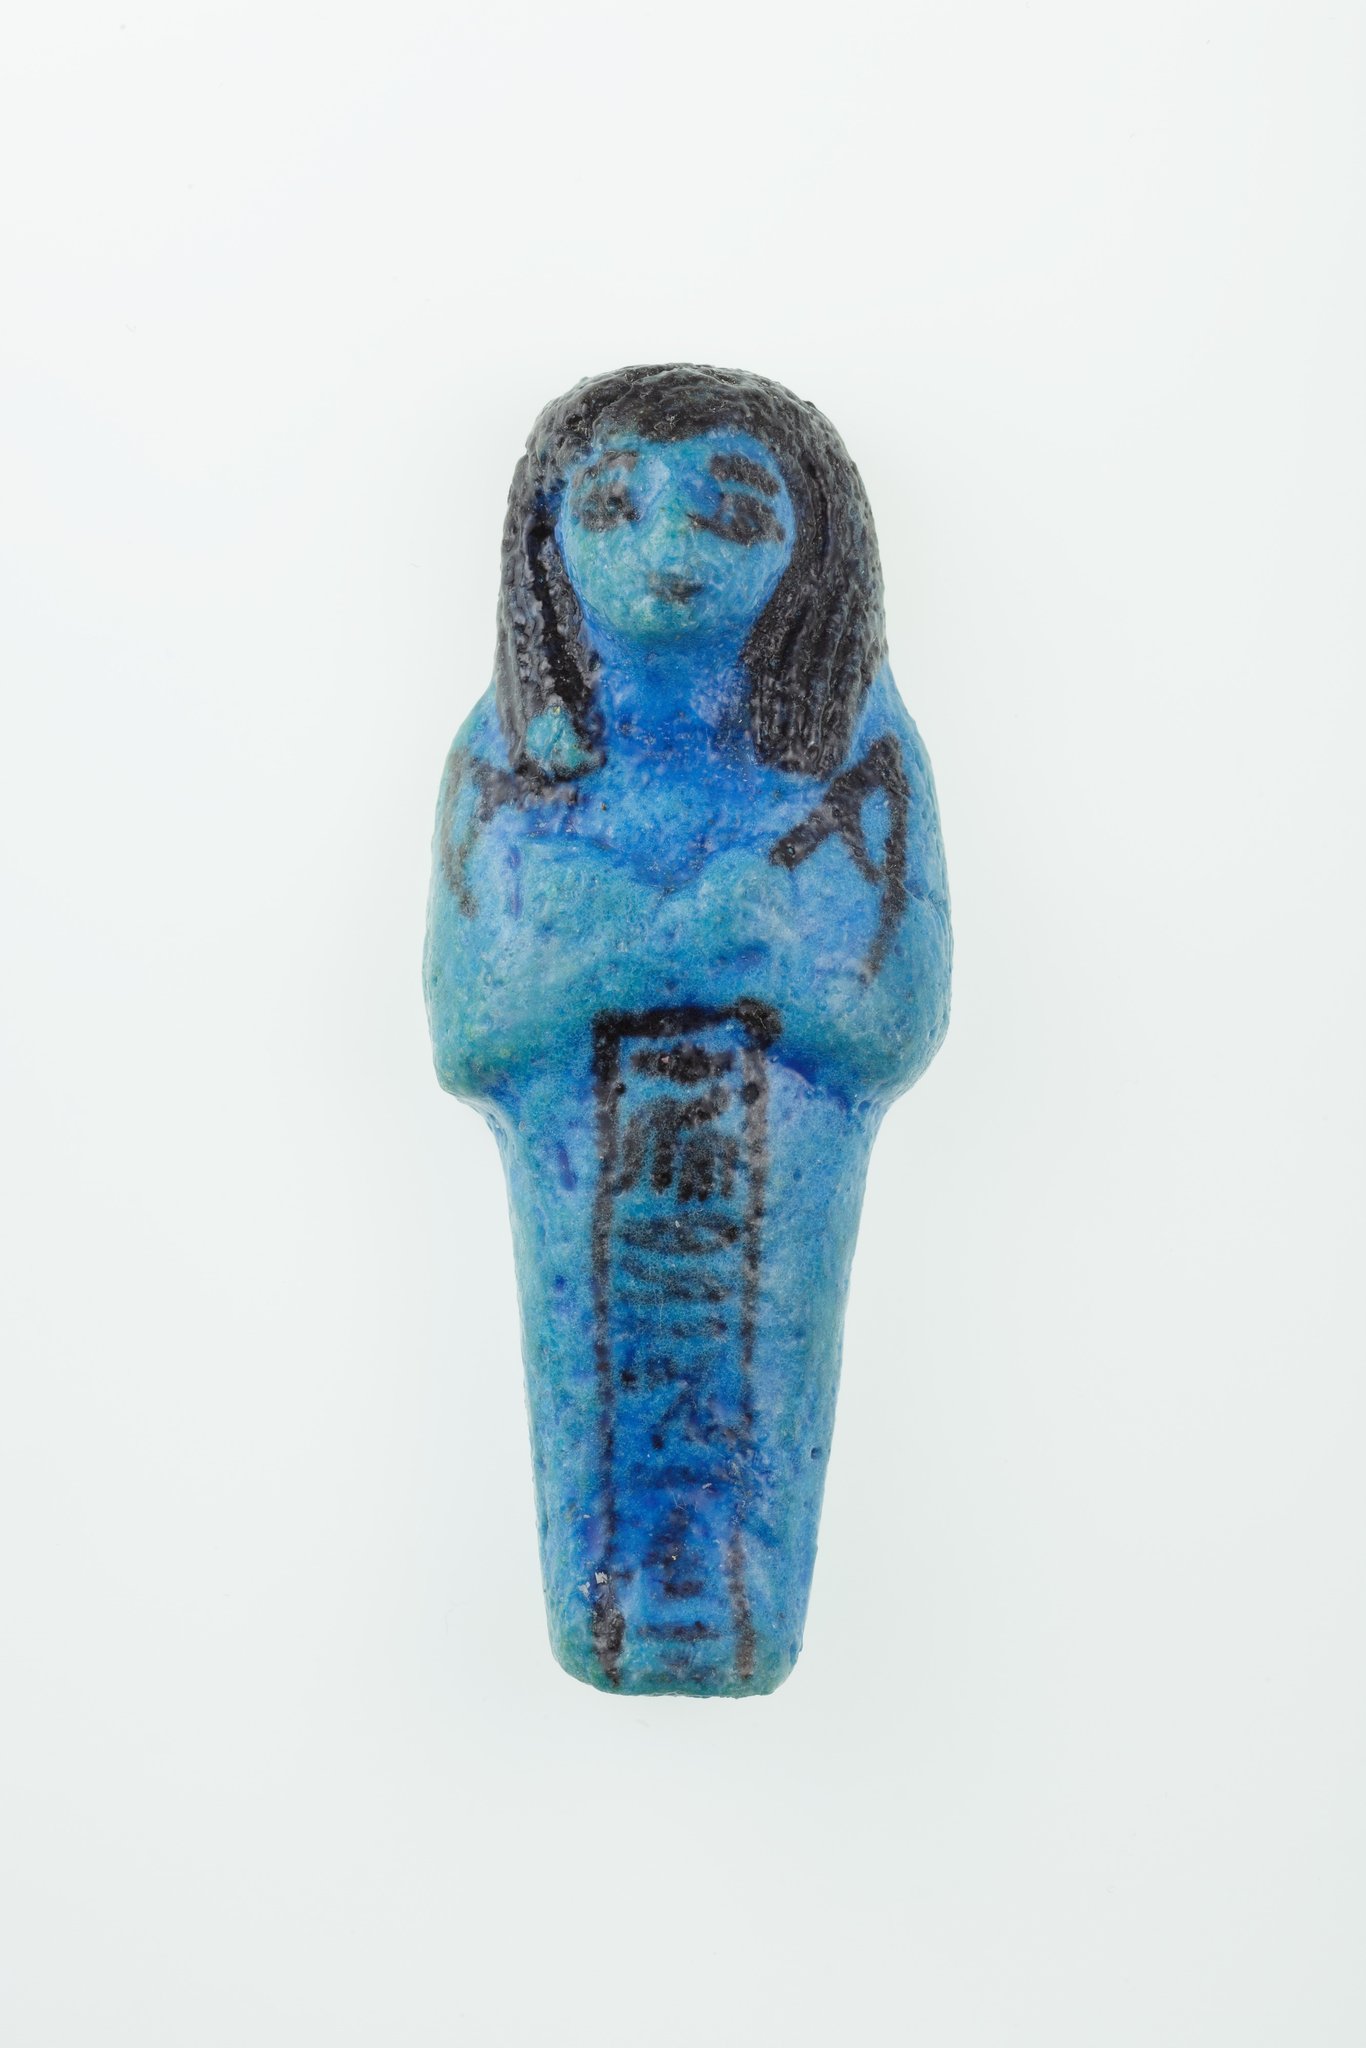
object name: shabti, worker, nauny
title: Worker Shabti of Nauny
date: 1050 BCE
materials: faience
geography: egypt